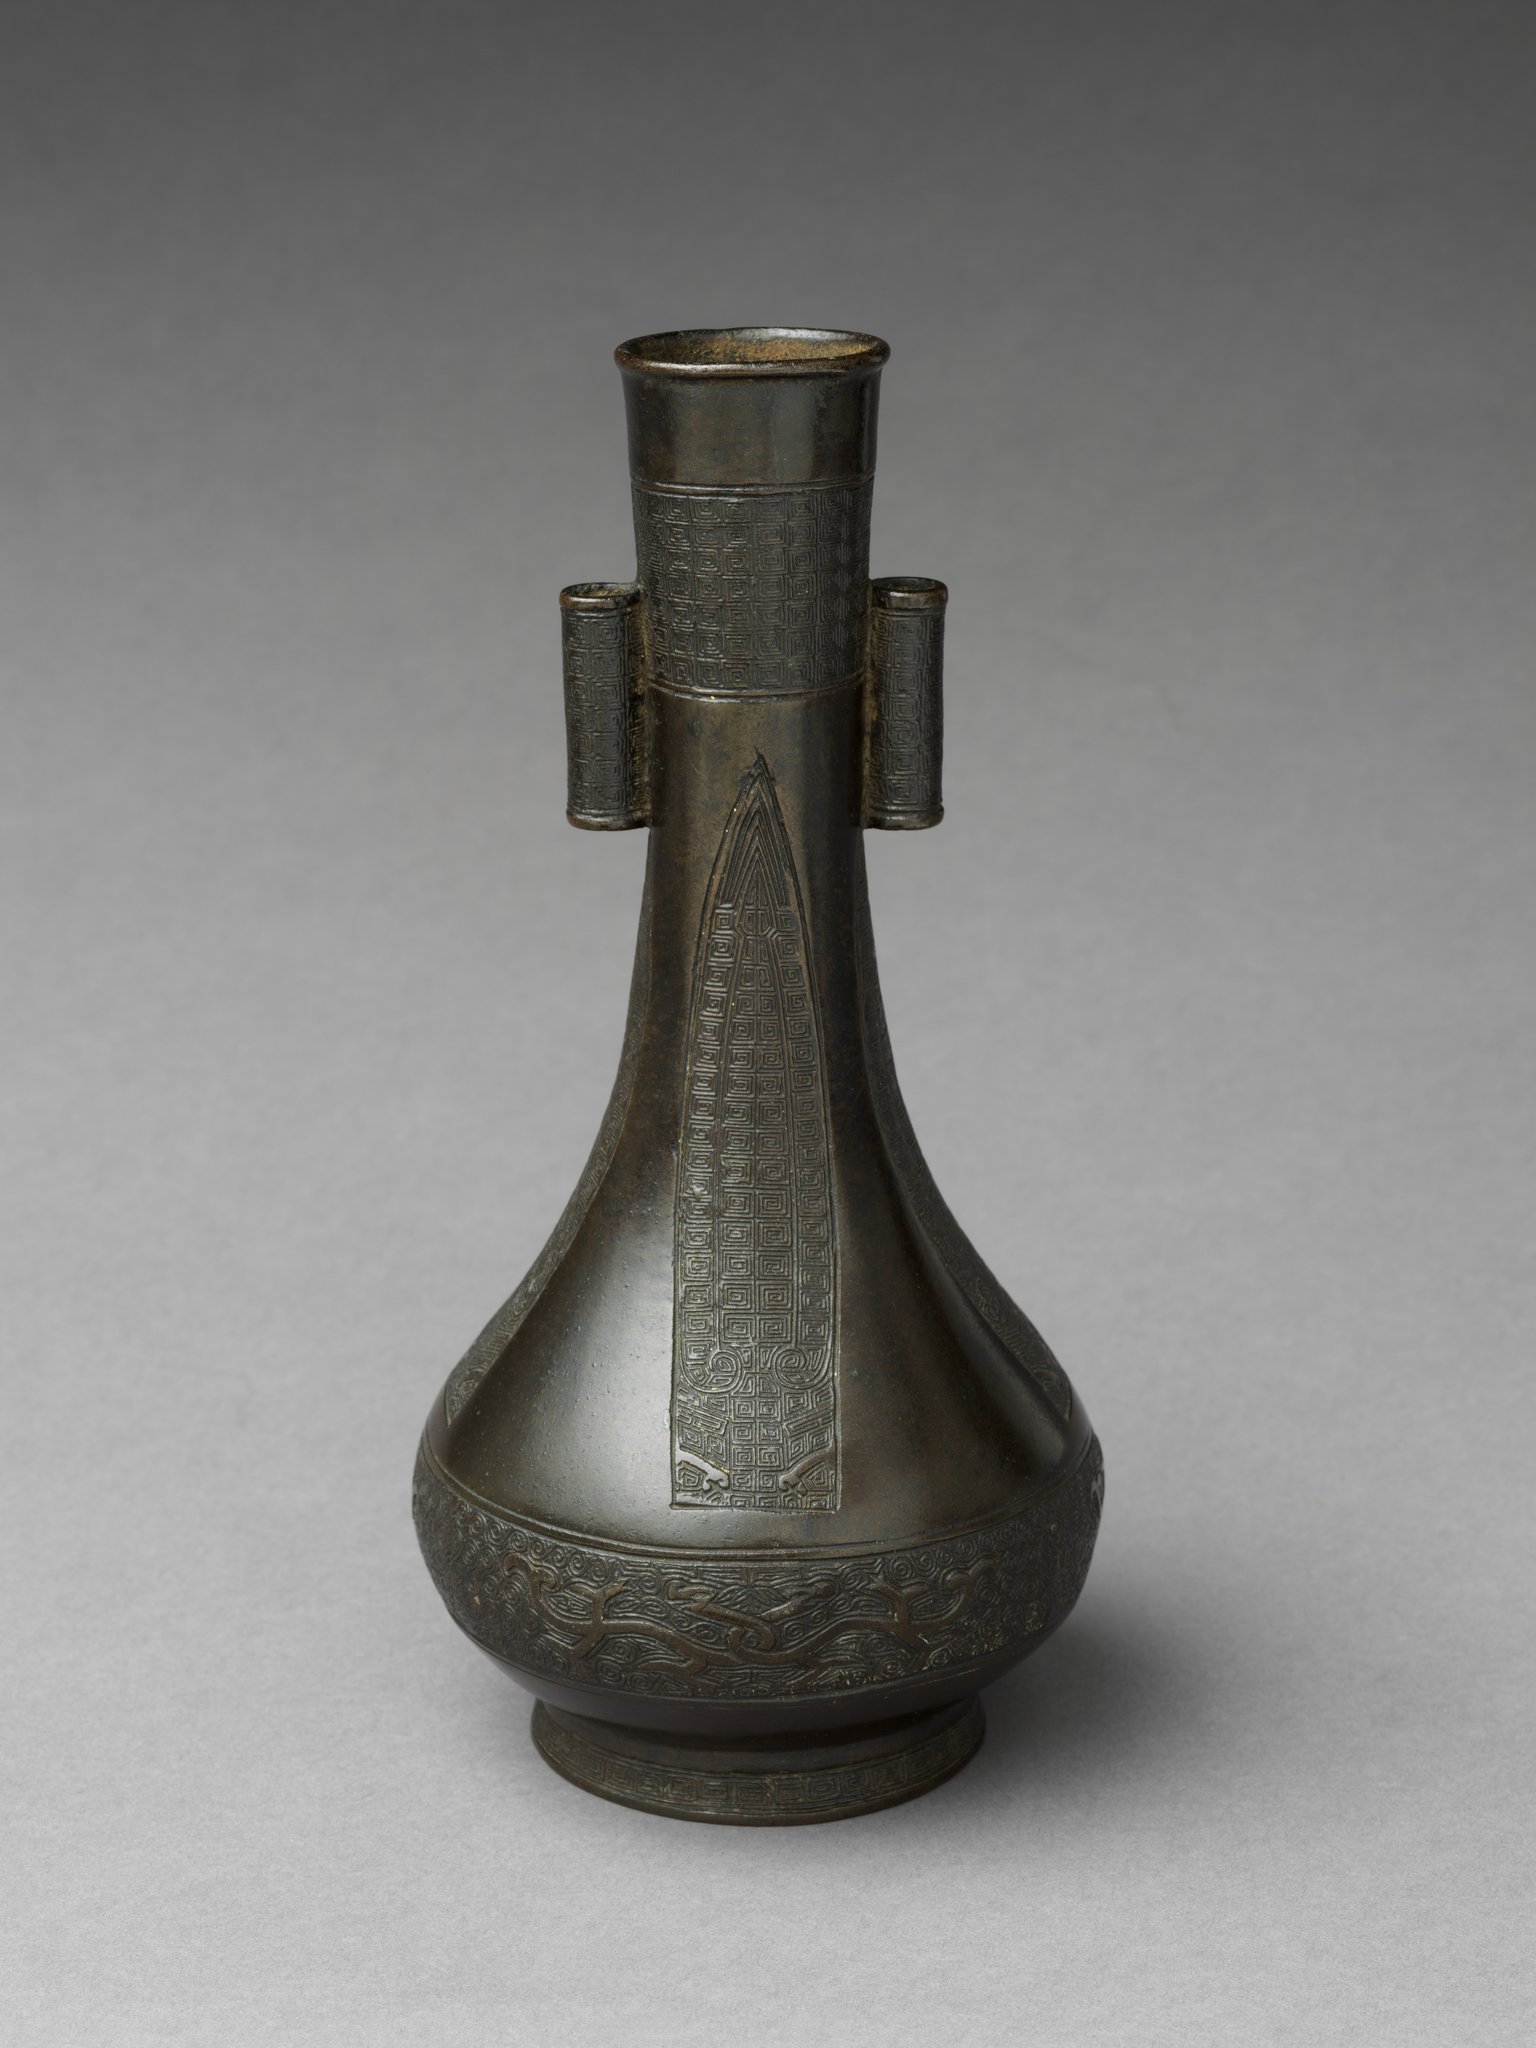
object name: vase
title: Long neck vase with tubular handles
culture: chinese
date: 1201-1300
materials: copper alloy